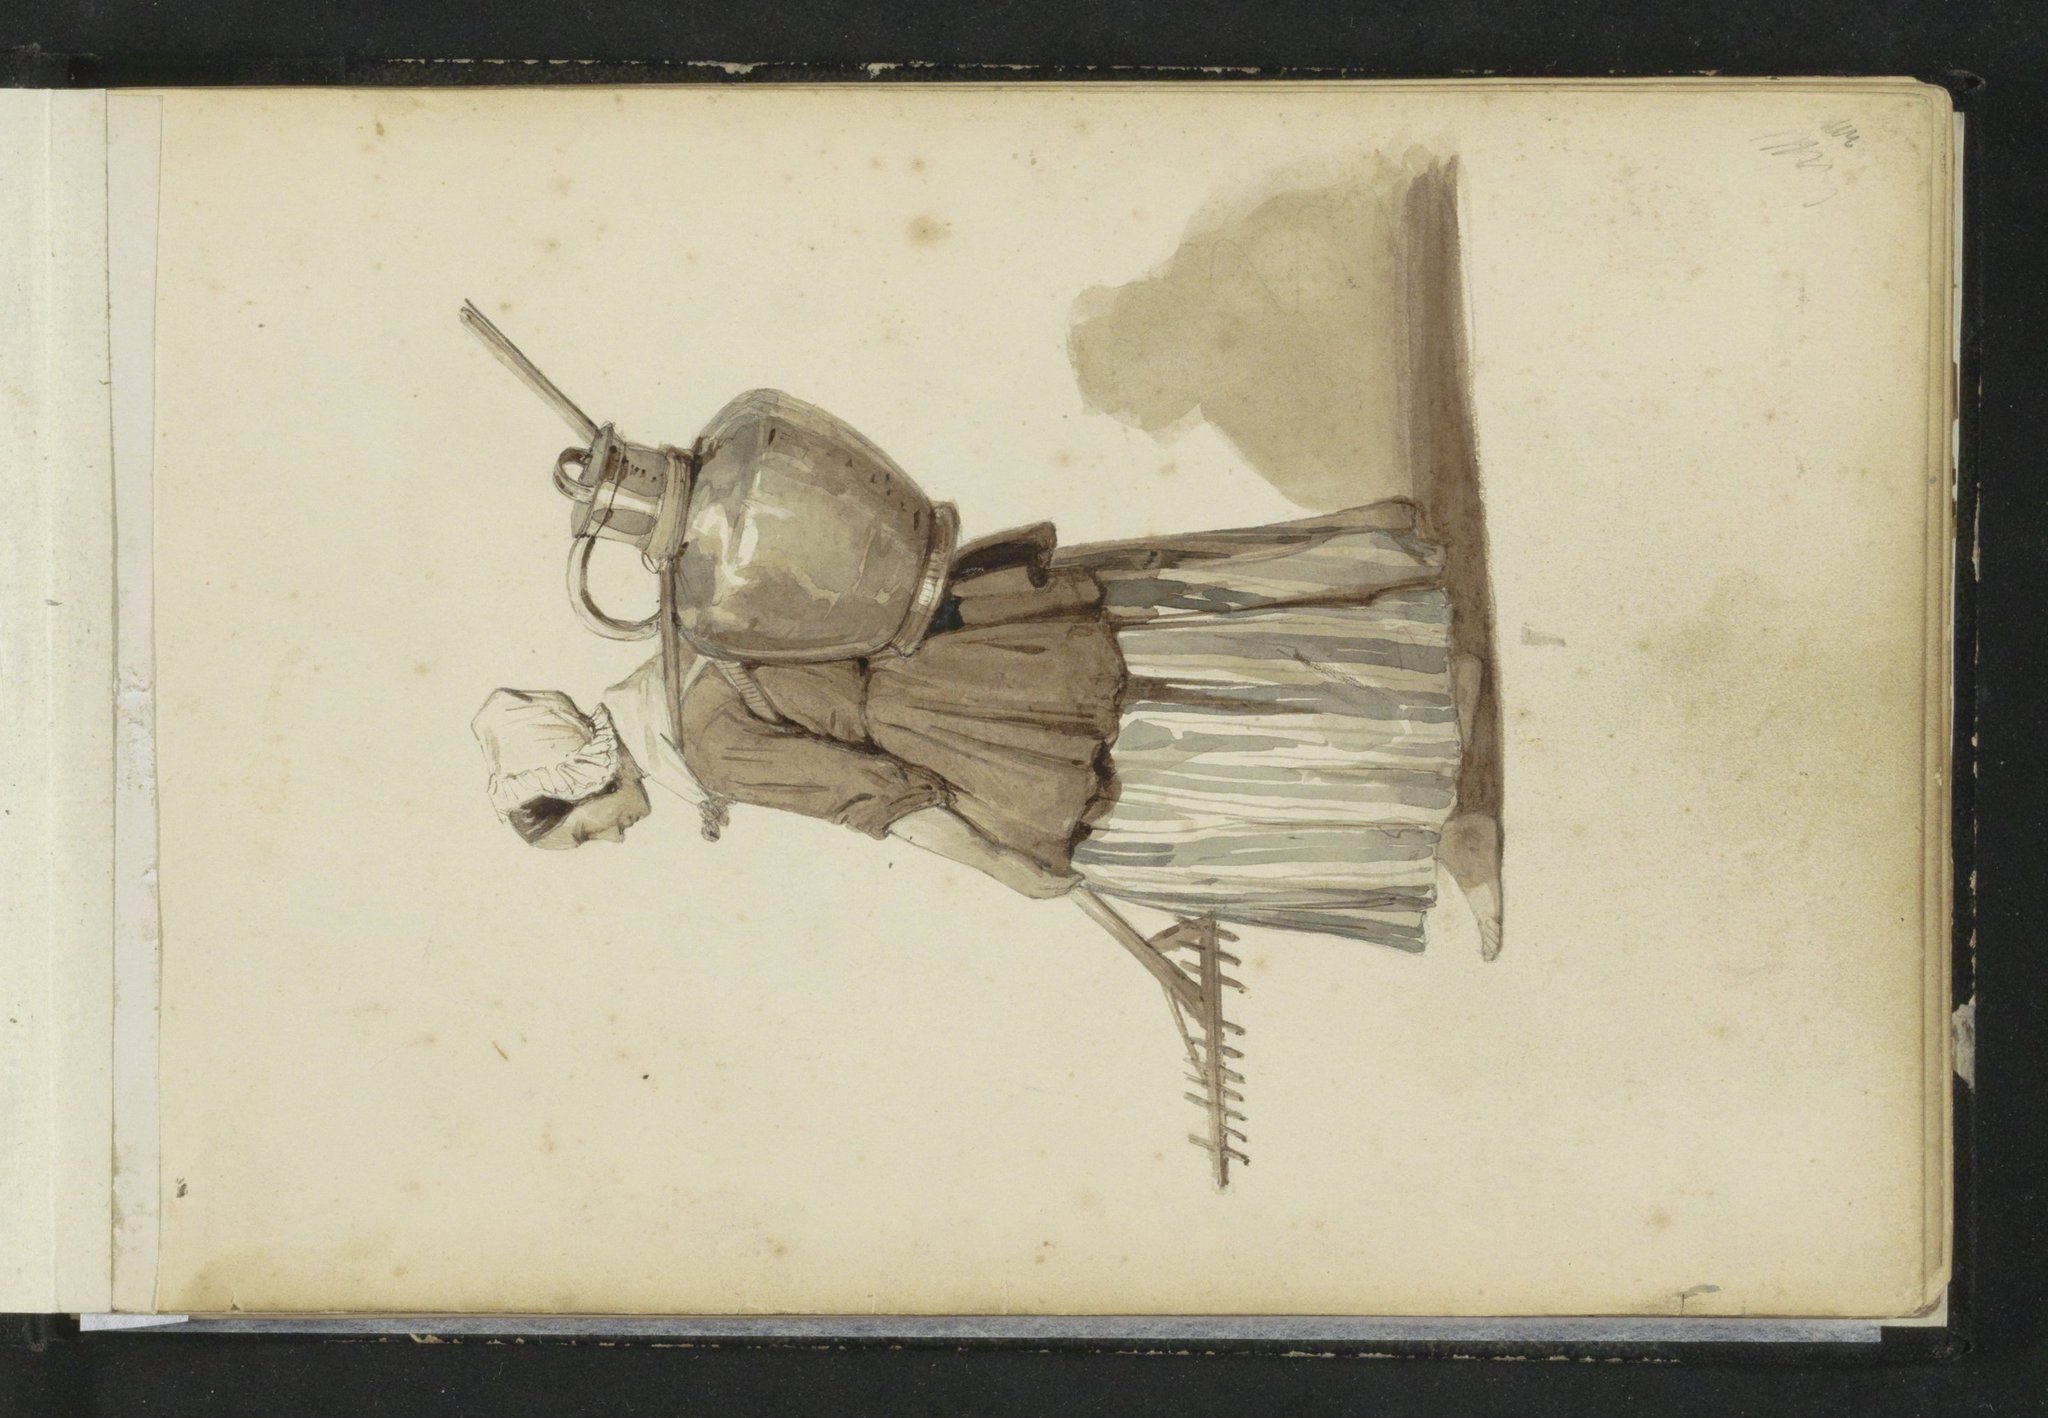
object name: sketchbook leaf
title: Boerin met een kan een een hark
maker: cornelis springer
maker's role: draughtsman, painter, print maker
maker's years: 1817-1891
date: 1846-1882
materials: paper, pencil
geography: netherlands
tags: adolescent, young woman, maiden, farmers - aa - female farmer, farmer's wife, container of ceramics: jar, jug, pot, vase, agricultural implements: rake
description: Boerin met een kan op haar rug en een hark in haar hand. Blad 1 uit een schetsboek met 91 bladen.